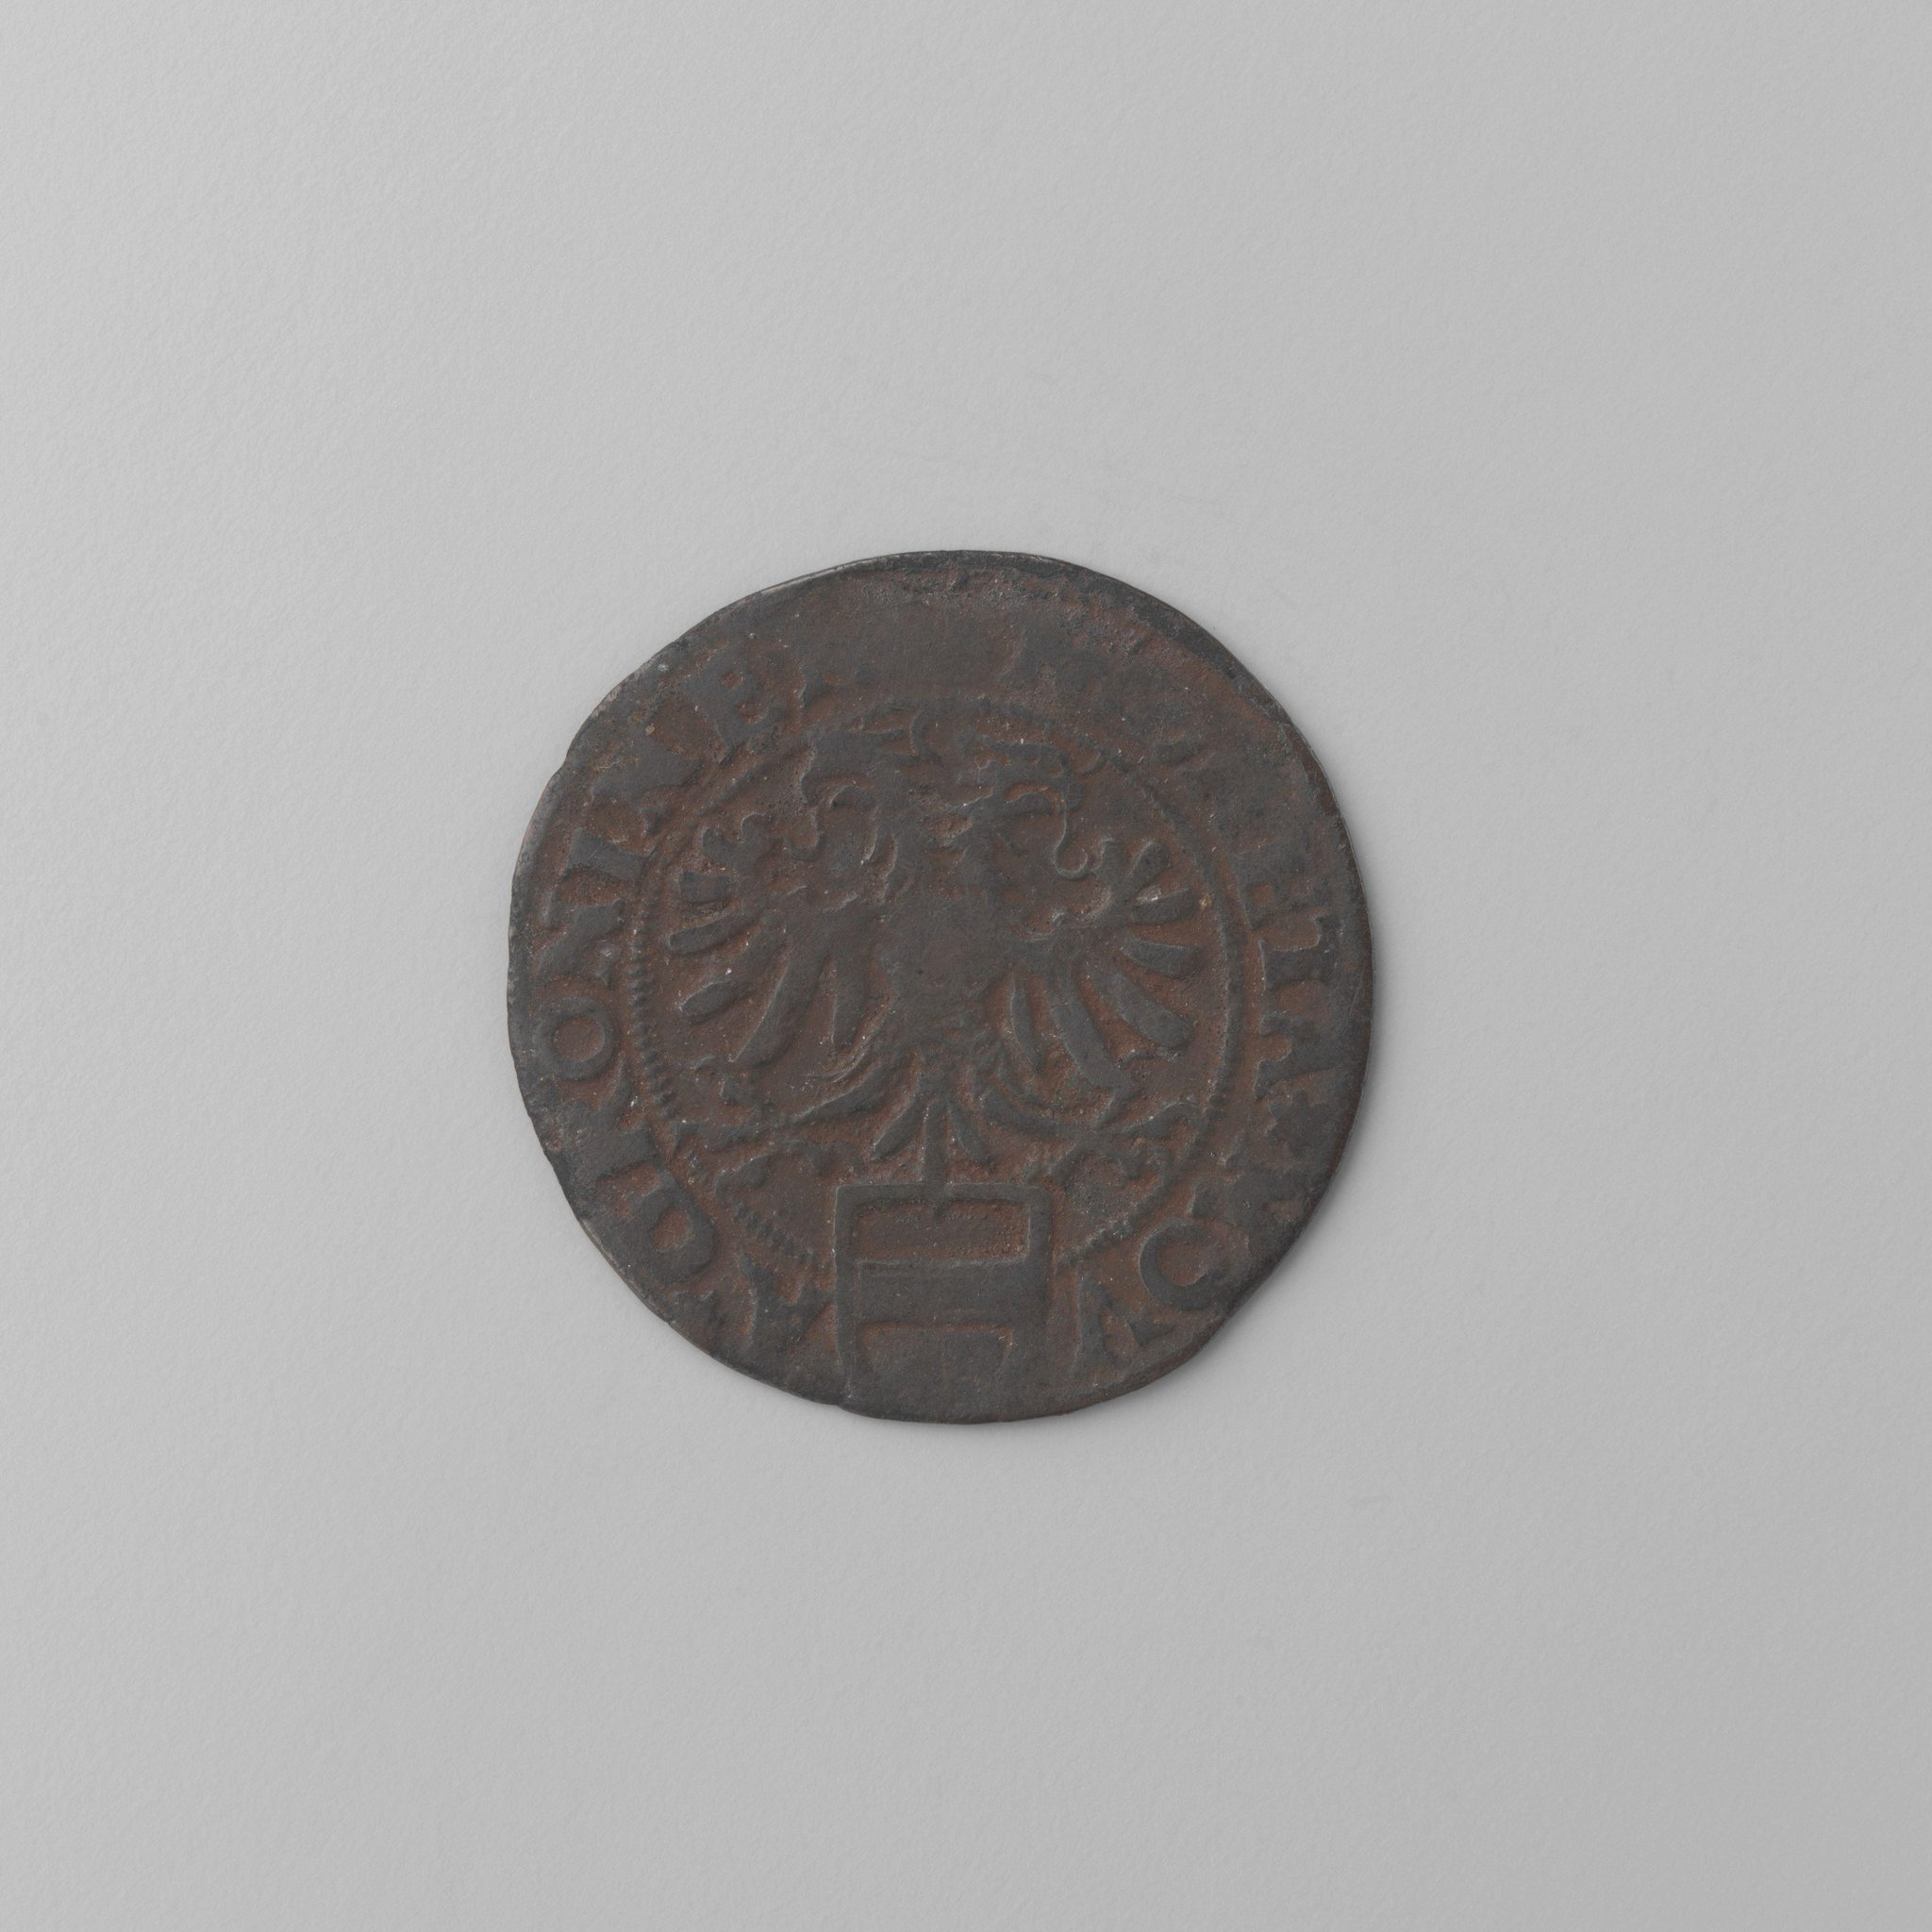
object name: coin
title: Gronings magermanneke, 1579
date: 1579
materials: copper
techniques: striking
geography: groningen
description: Zilveren munt. Voorzijde: dubbelkoppige adelaar, tussen de koppren letter G, onder adelaar wapenschild. Keerzijde: lang versierd kruis. Tussen de benen een blaadje of cirkeltje, in het hart de letter G. Jaartal in omschrift.